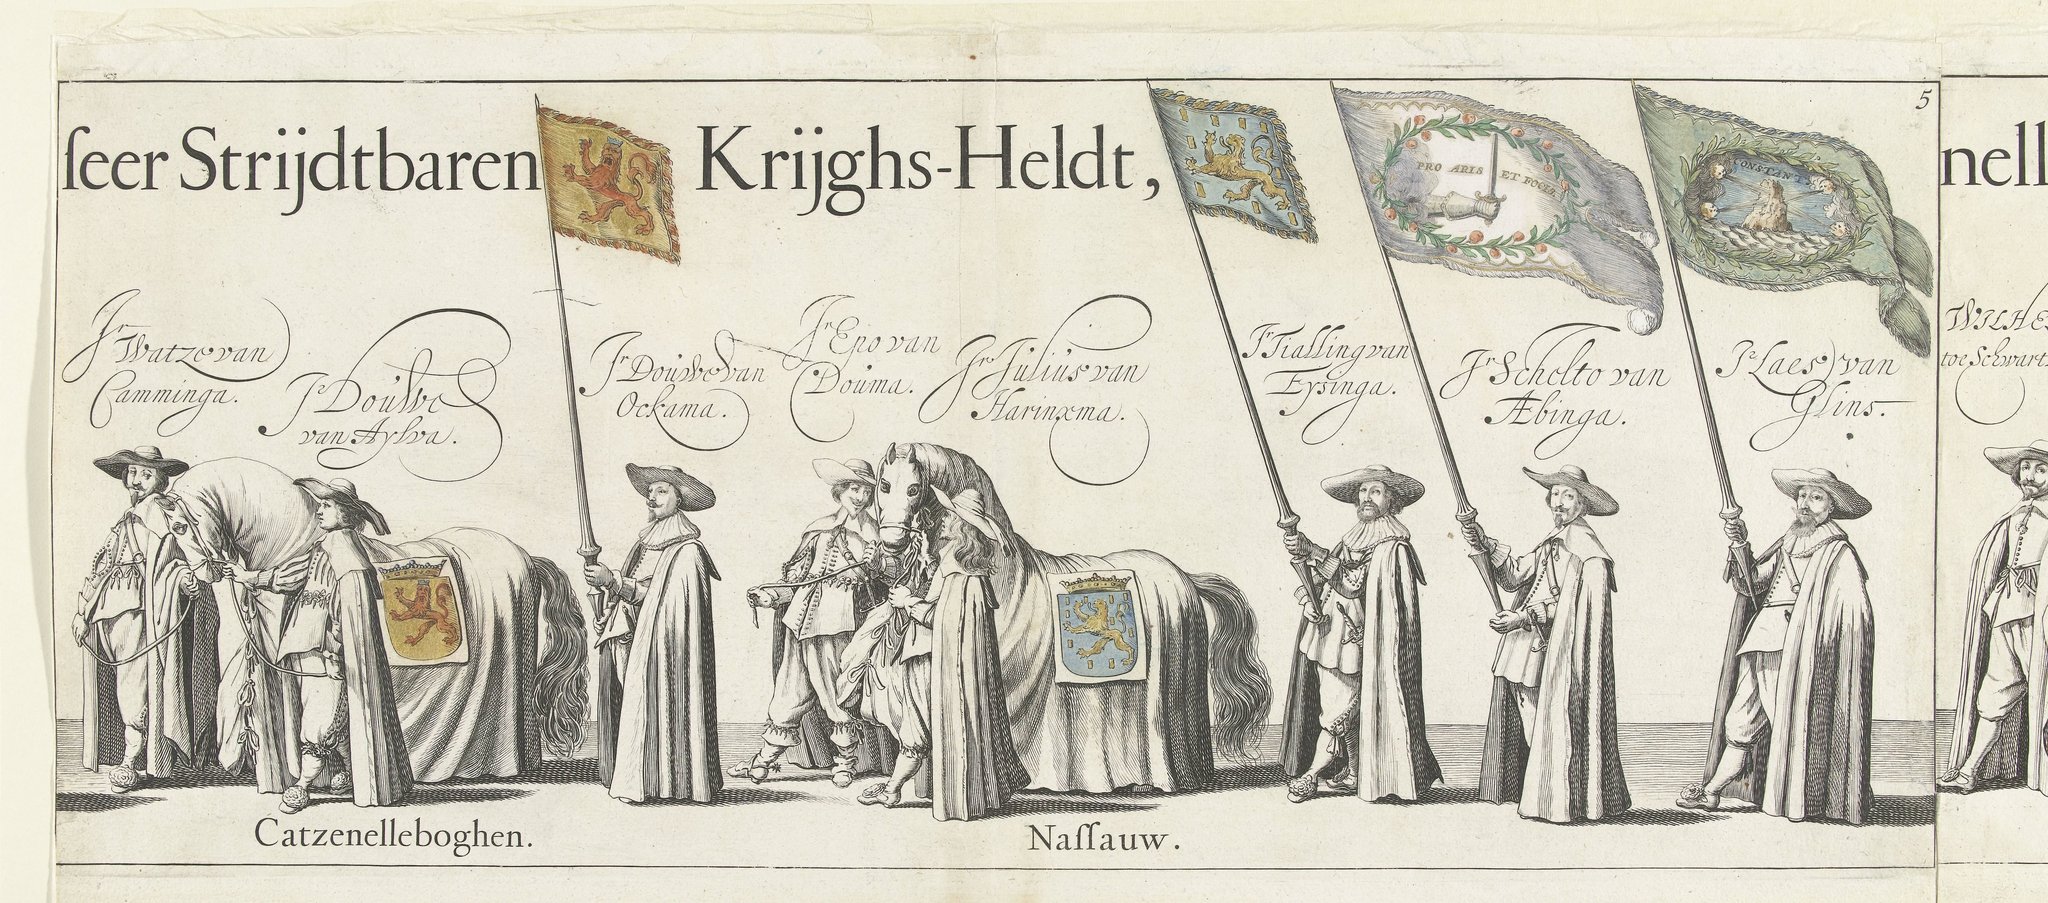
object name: print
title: Begrafenis van Ernst Casimir, graaf van Nassau-Dietz te Leeuwarden, 1633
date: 1634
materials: paper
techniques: engraving, etching, hand coloring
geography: northern netherlands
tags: ernst casimir graaf van nassau-dietz, cortege, funeral procession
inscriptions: date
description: Deel van de begrafenisstoet met een paard en vaandeldragers. Bovenin de namen van de afgebeelde personen. Plaat nr. 5 in de prentserie van de begrafenis van Ernst Casimir, graaf van Nassau-Dietz te Leeuwarden, 3 januari 1633. De wapens en vaandels zijn ingekleurd. Dit blad samen met bladen 6, 7 en 8 aan elkaar geplakt.